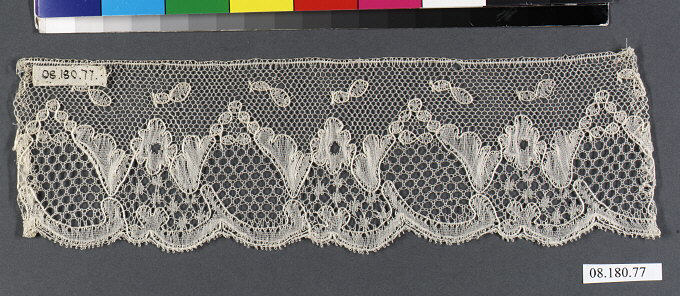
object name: fragment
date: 1801-1900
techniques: lace